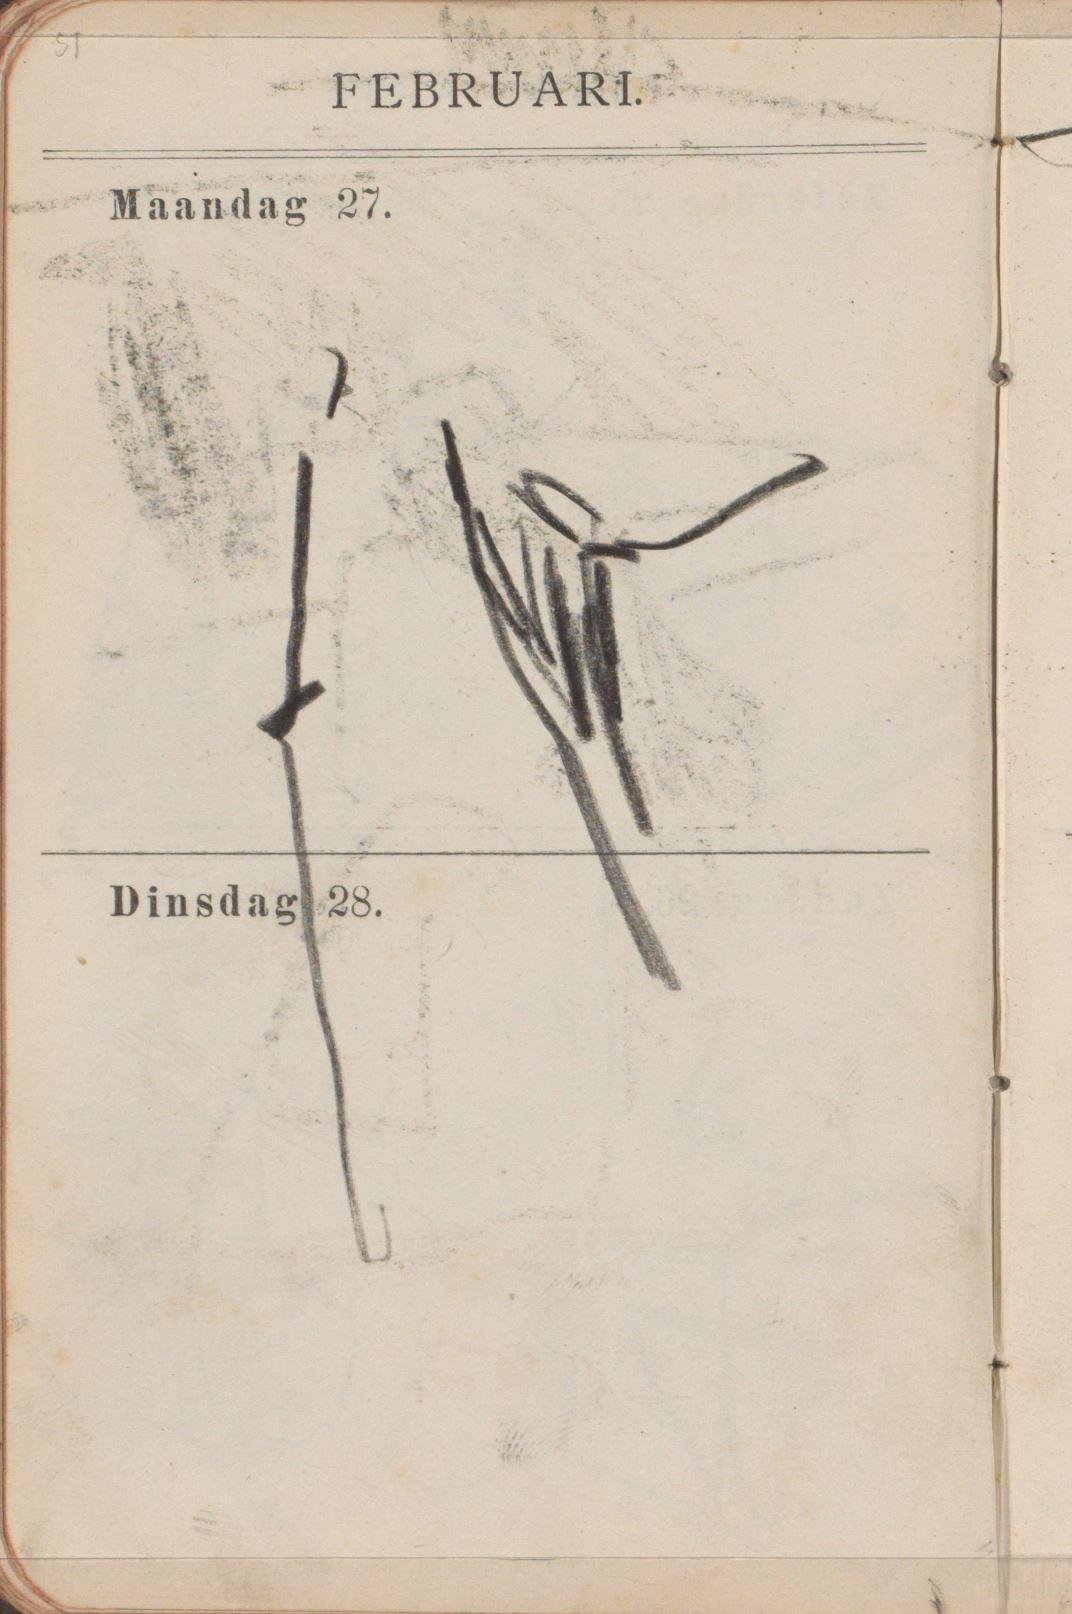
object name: sketchbook leaf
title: Studie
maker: george hendrik breitner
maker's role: draughtsman, painter, print maker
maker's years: 1857-1923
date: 1893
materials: chalk, paper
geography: amsterdam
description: Pagina 51 uit een als schetsboek gebruikte agenda met 108 bladen.